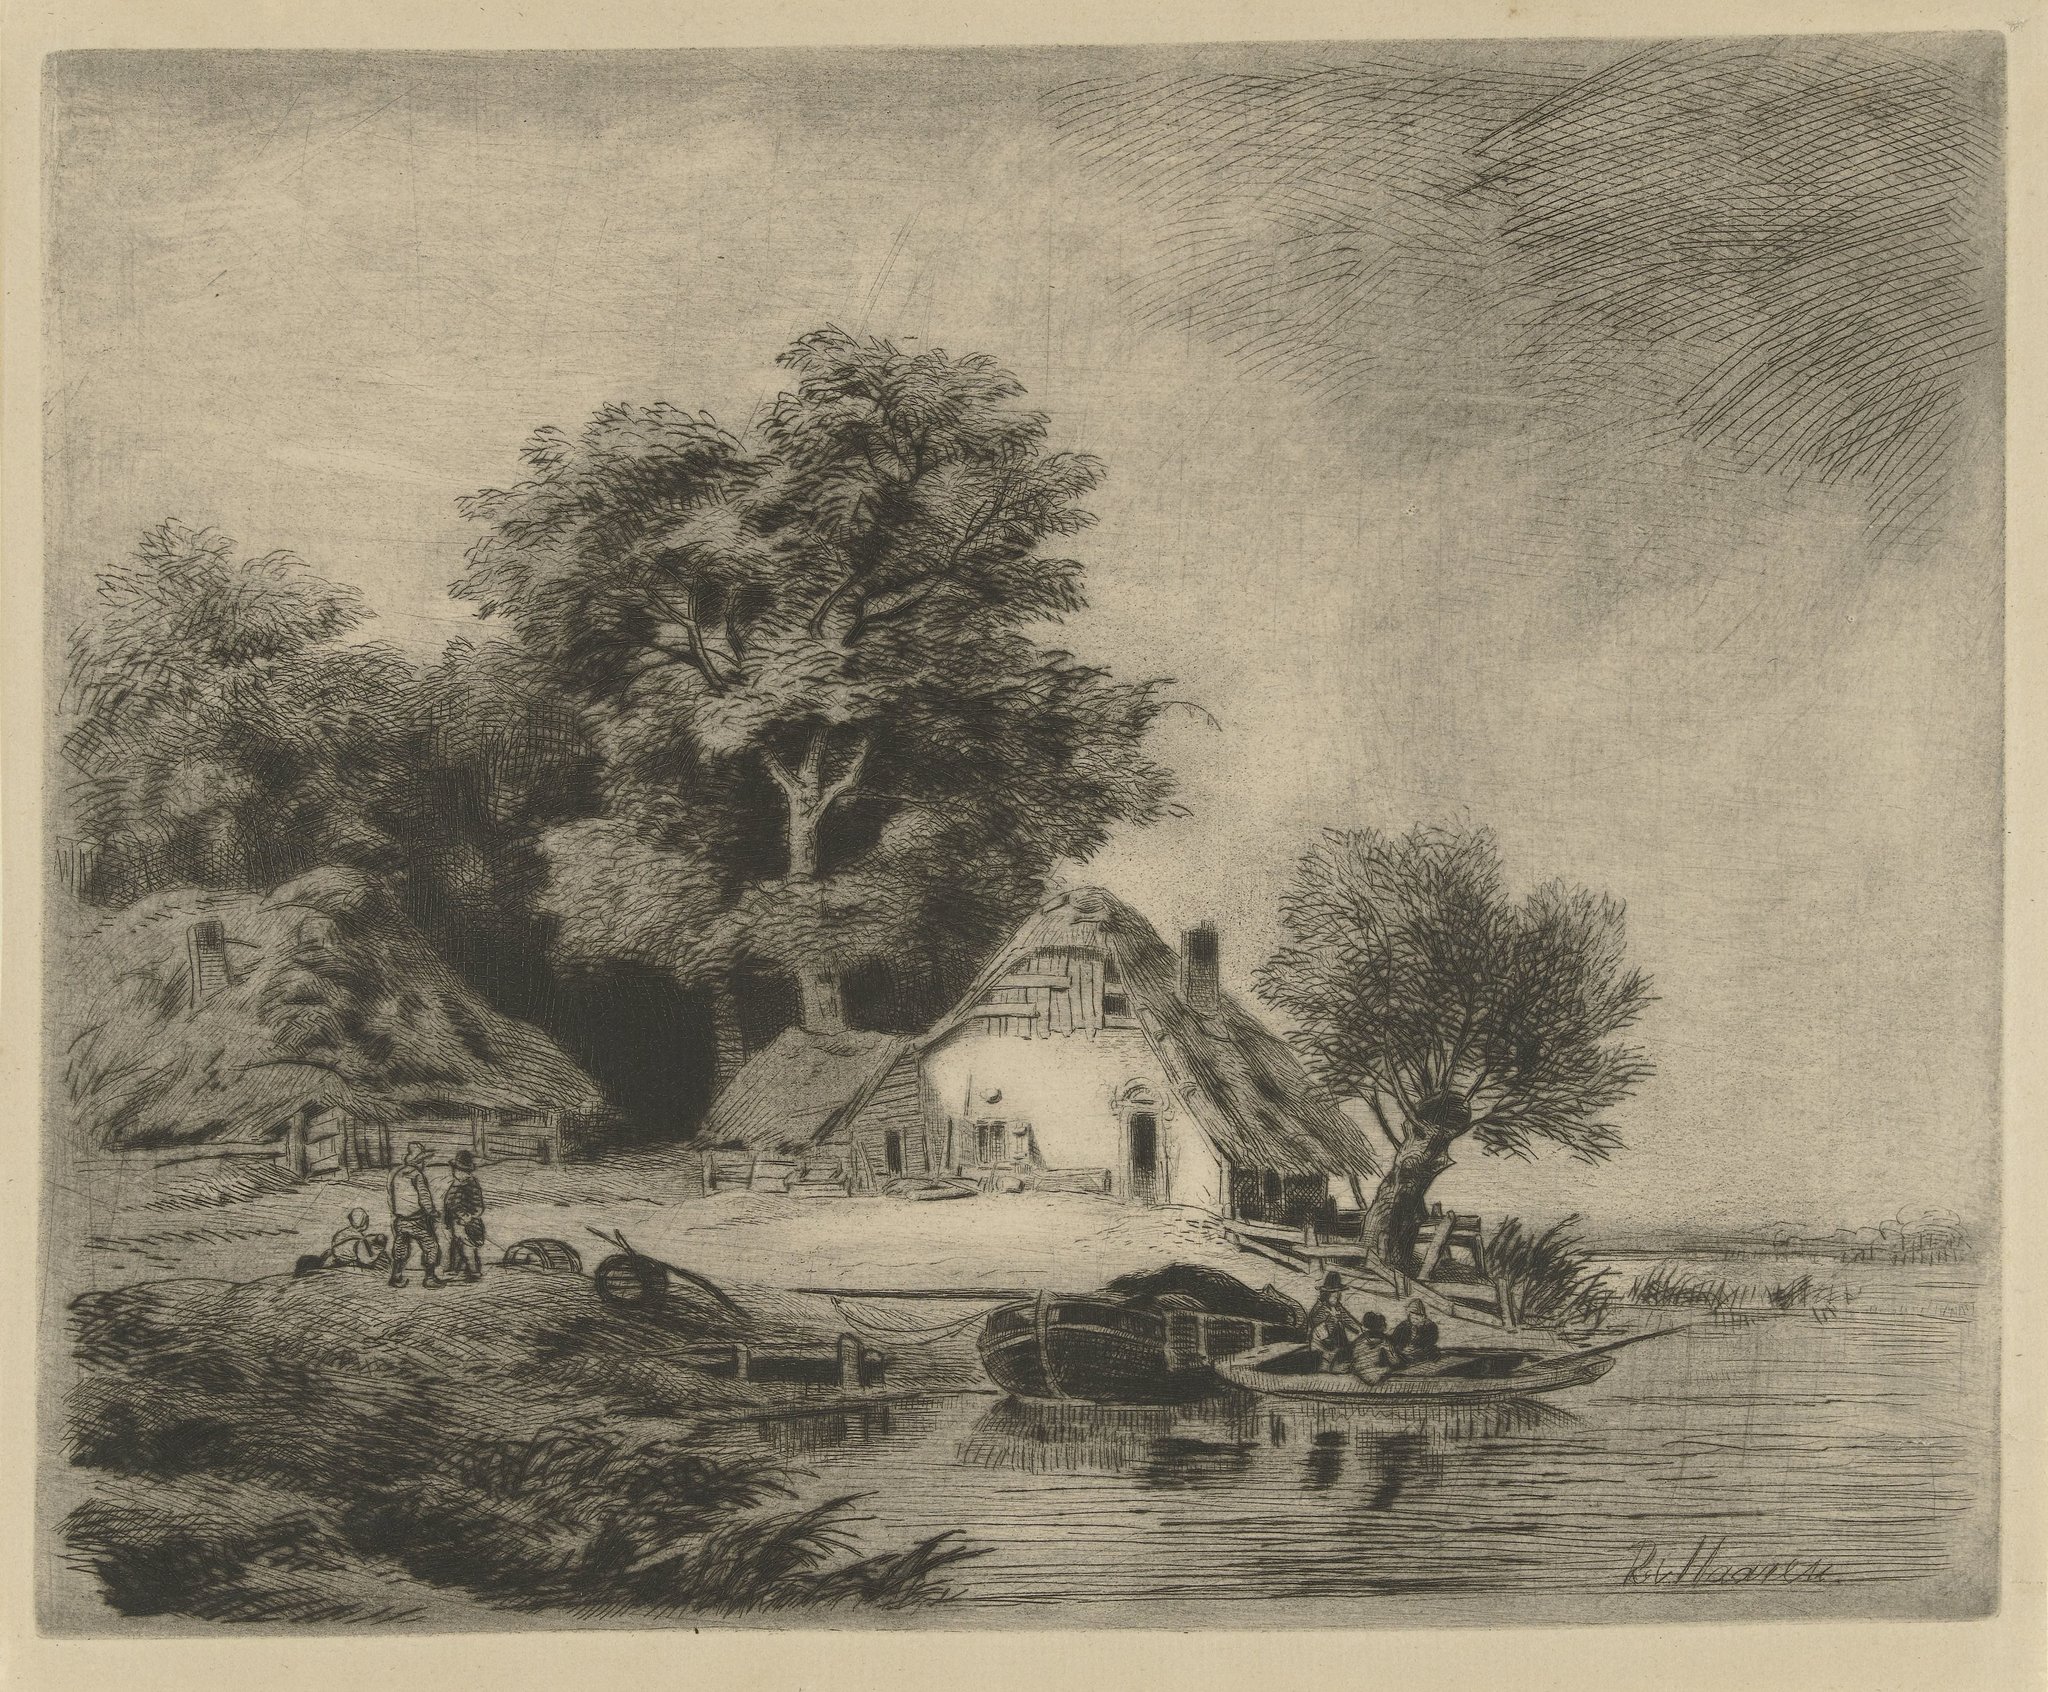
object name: print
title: Boerderij aan het water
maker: remigius adrianus haanen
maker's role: draughtsman, painter, print maker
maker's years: 1812-1894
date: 1827-1879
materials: paper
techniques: aquatint, drypoint, etching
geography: austria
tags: farm or solitary house in landscape (+ city(-scape) with figures, staffage)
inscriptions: collector's mark: Lugt 2228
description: Een boerderij naast een bomenrij aan het water, twee boten aan de oever.